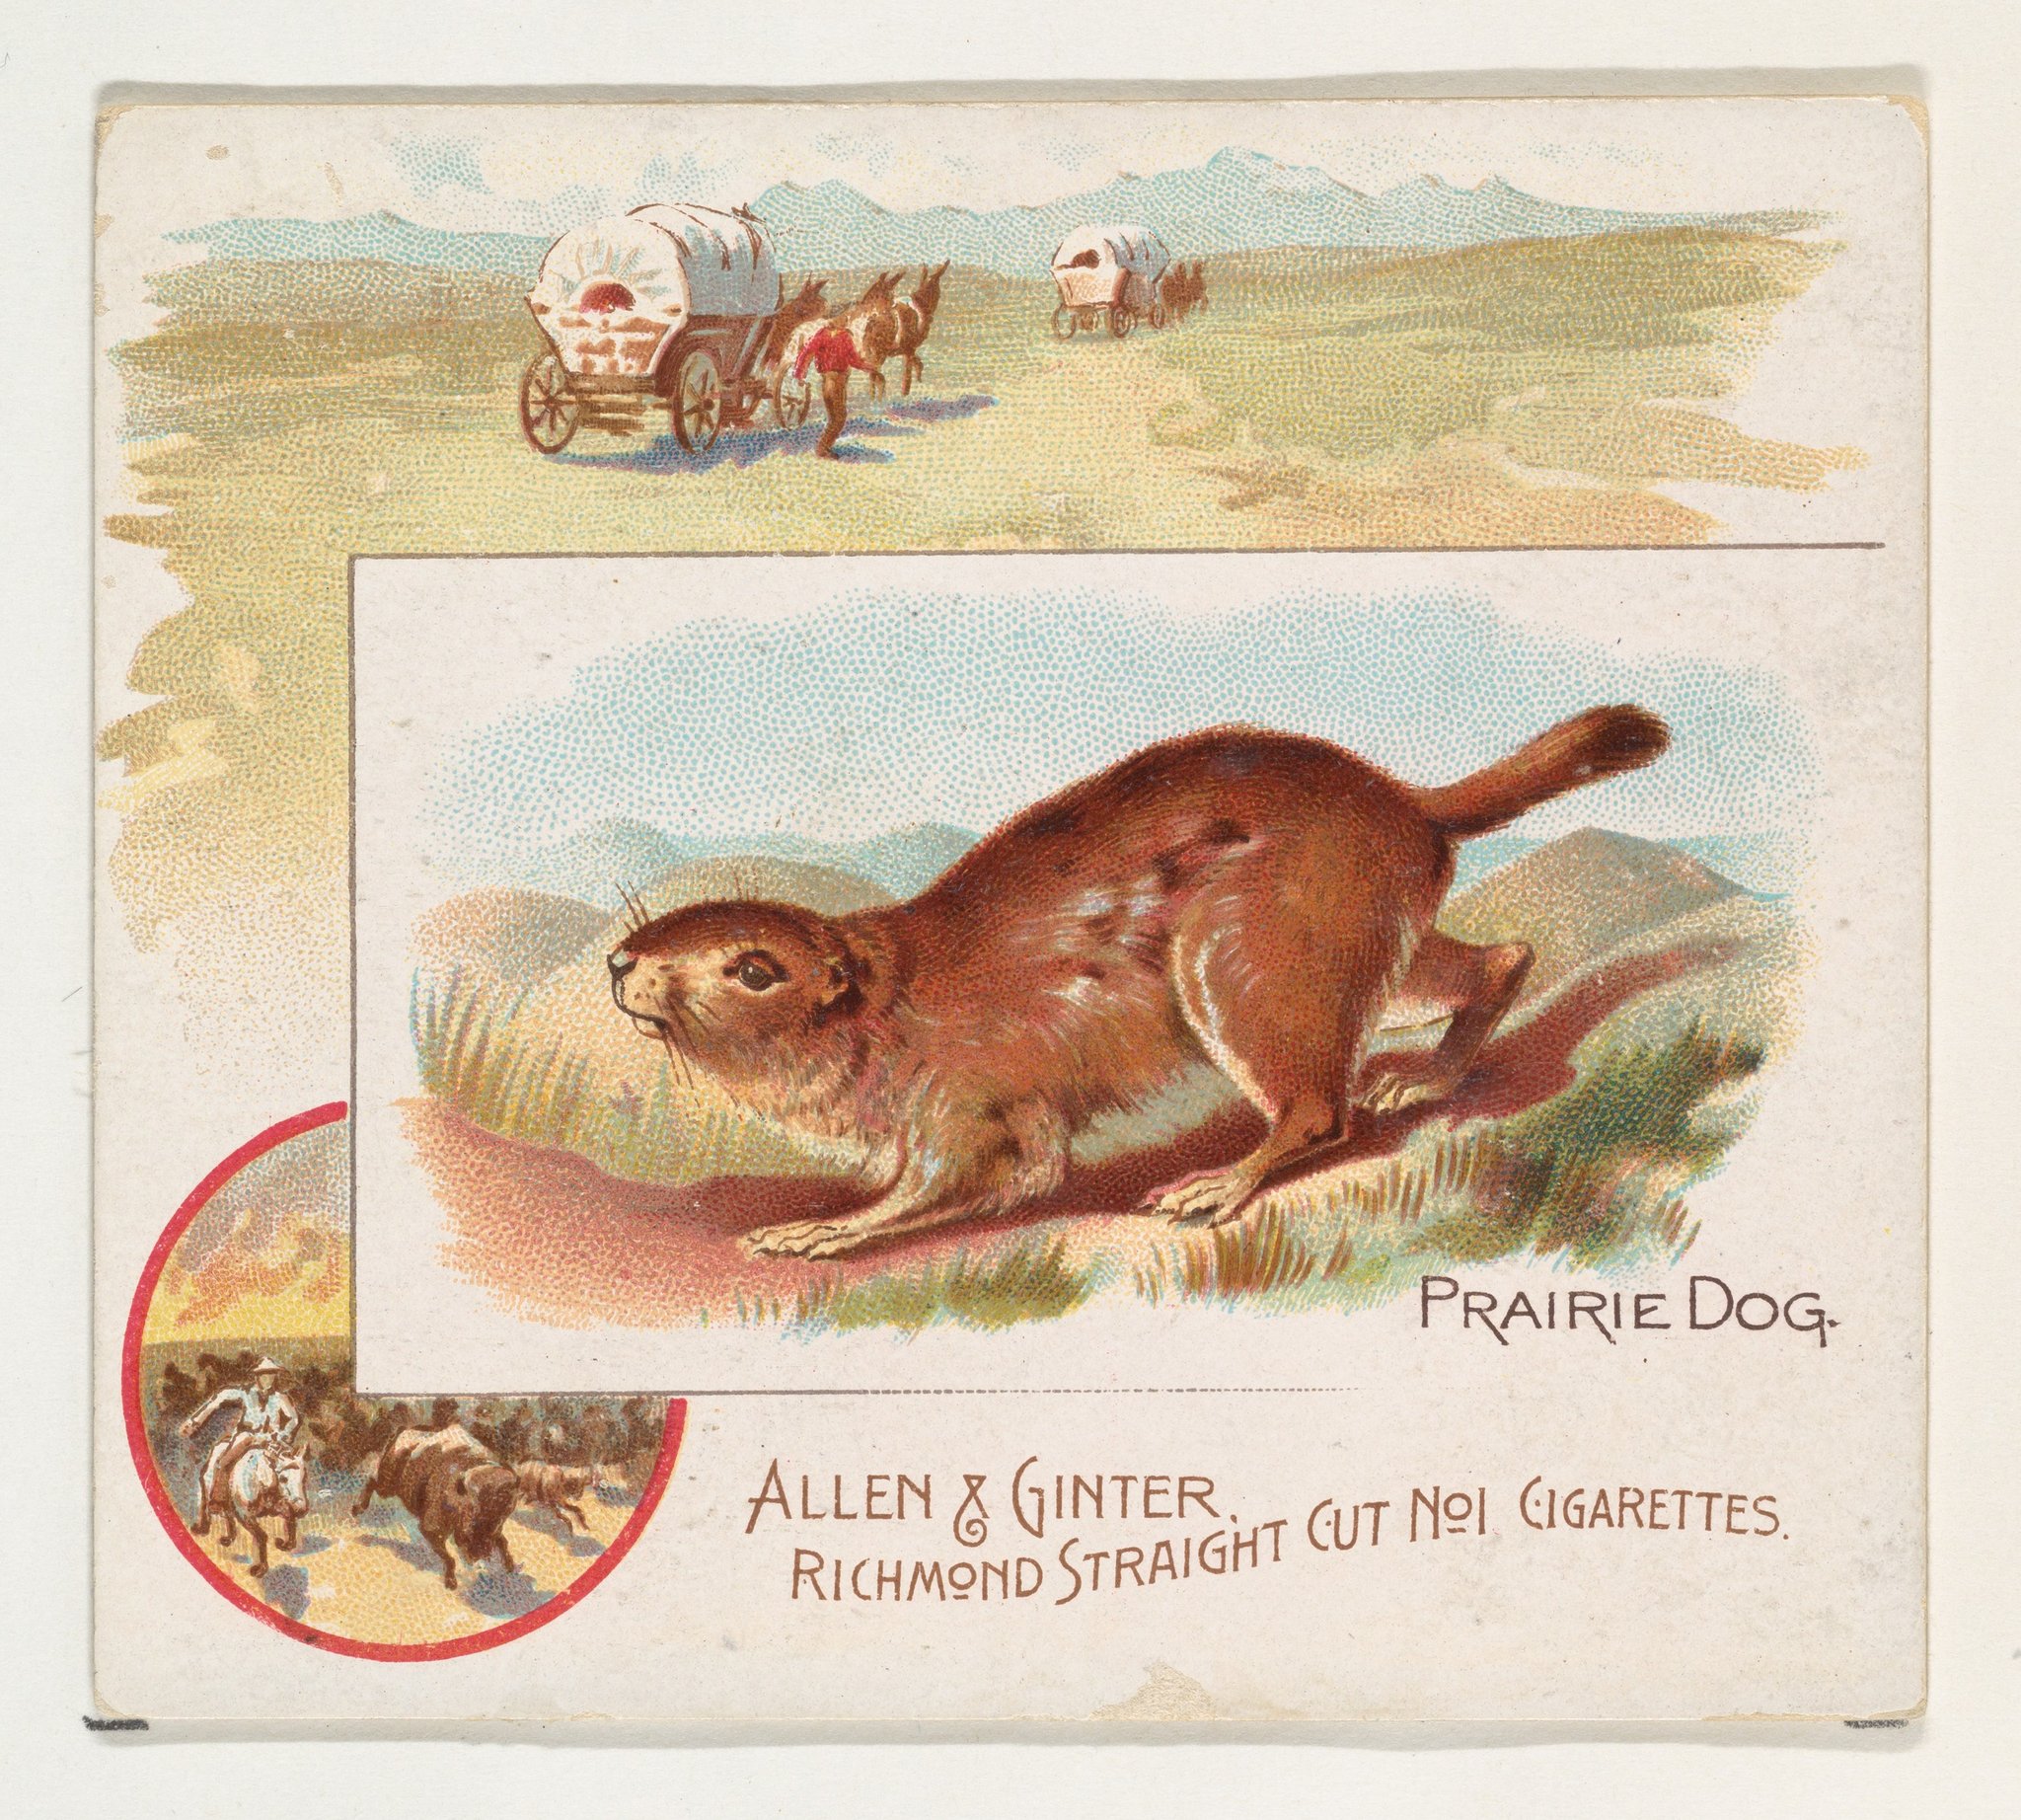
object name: print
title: Prairie Dog, from Quadrupeds series (N41) for Allen & Ginter Cigarettes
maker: allen & ginter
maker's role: publisher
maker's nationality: american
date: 1890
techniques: color lithograph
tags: animals